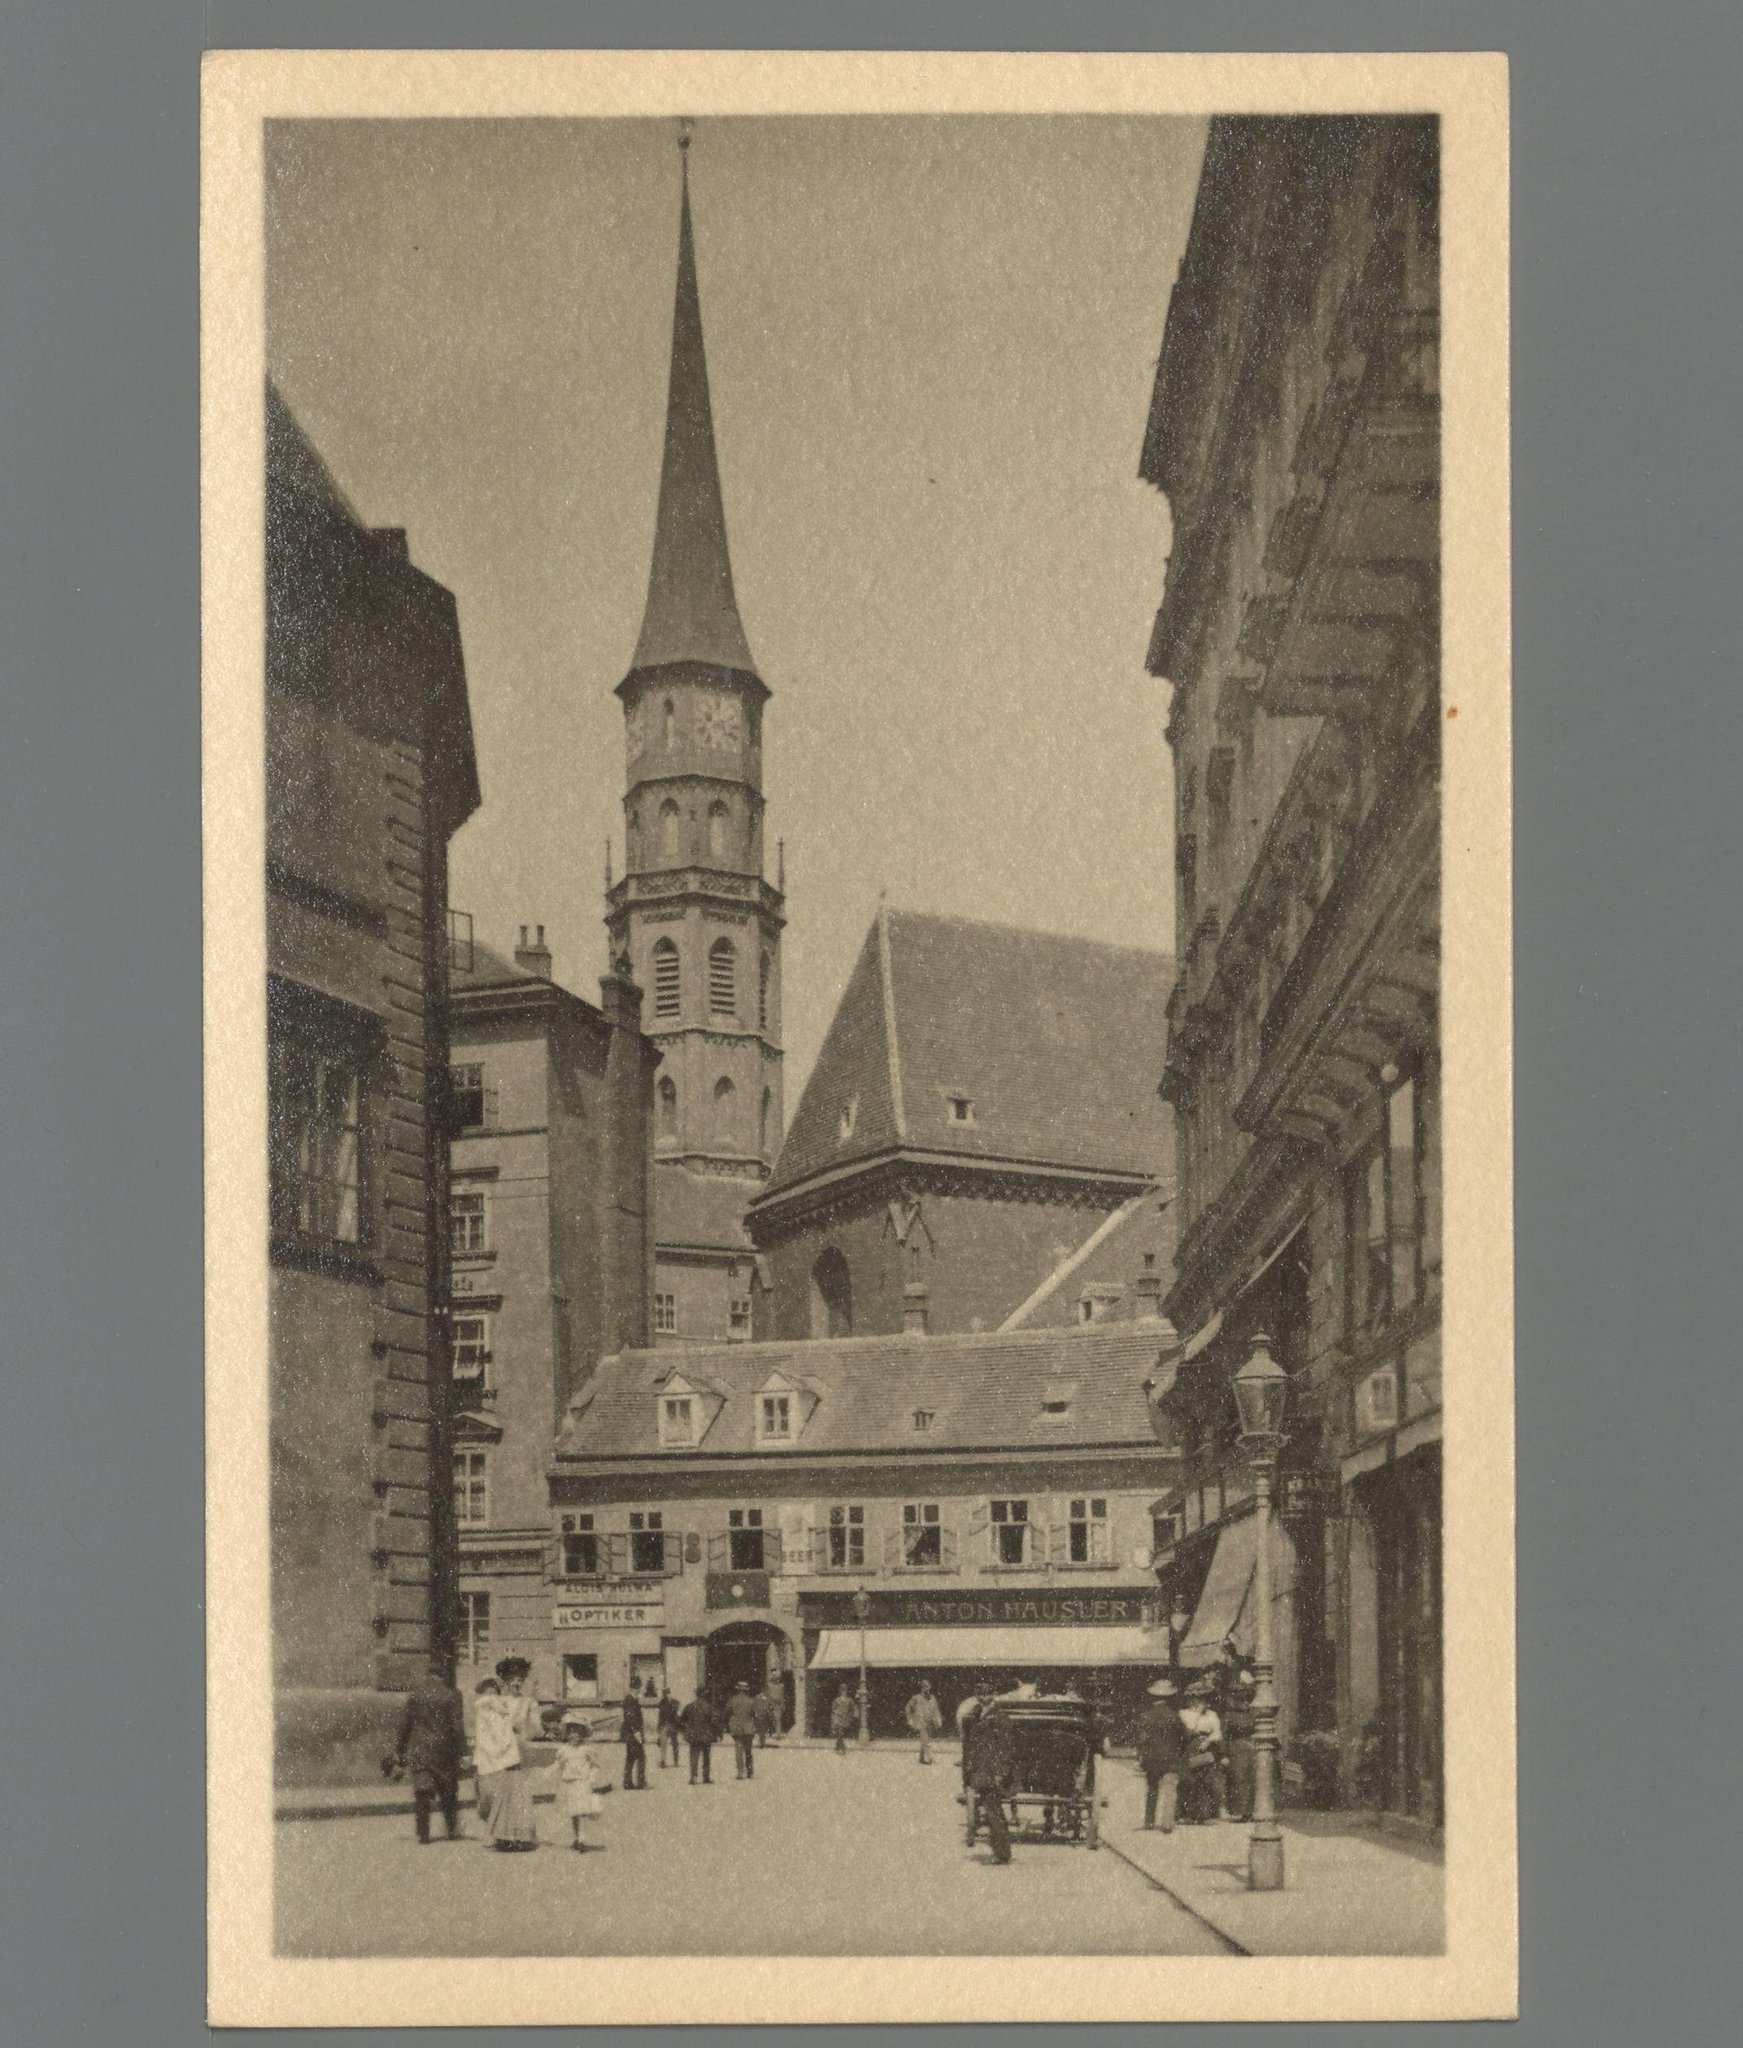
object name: photograph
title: Wien, I. Stallburggasse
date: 1904-1930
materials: paper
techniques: gelatin silver print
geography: vienna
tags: market, street, parts of church exterior and annexes: tower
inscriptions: inscription: ‘K.L. Wien’